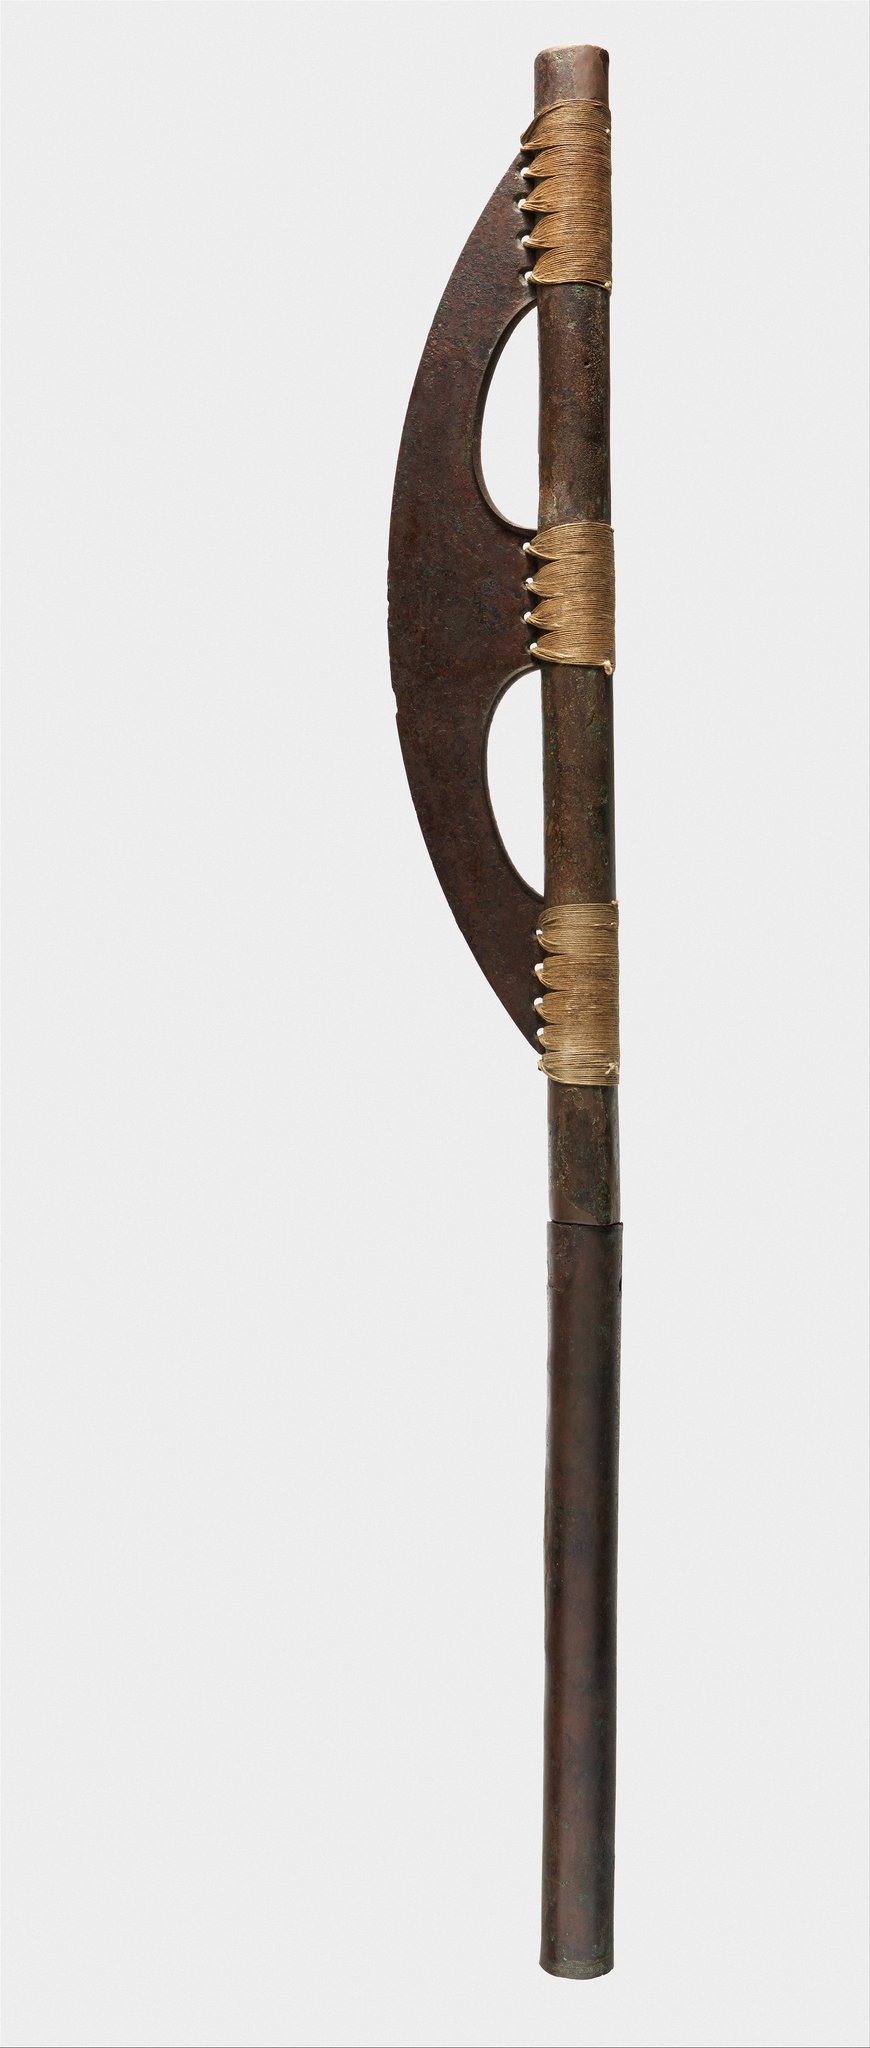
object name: ax, long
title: Battle-ax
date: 1981-1802 BCE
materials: bronze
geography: egypt